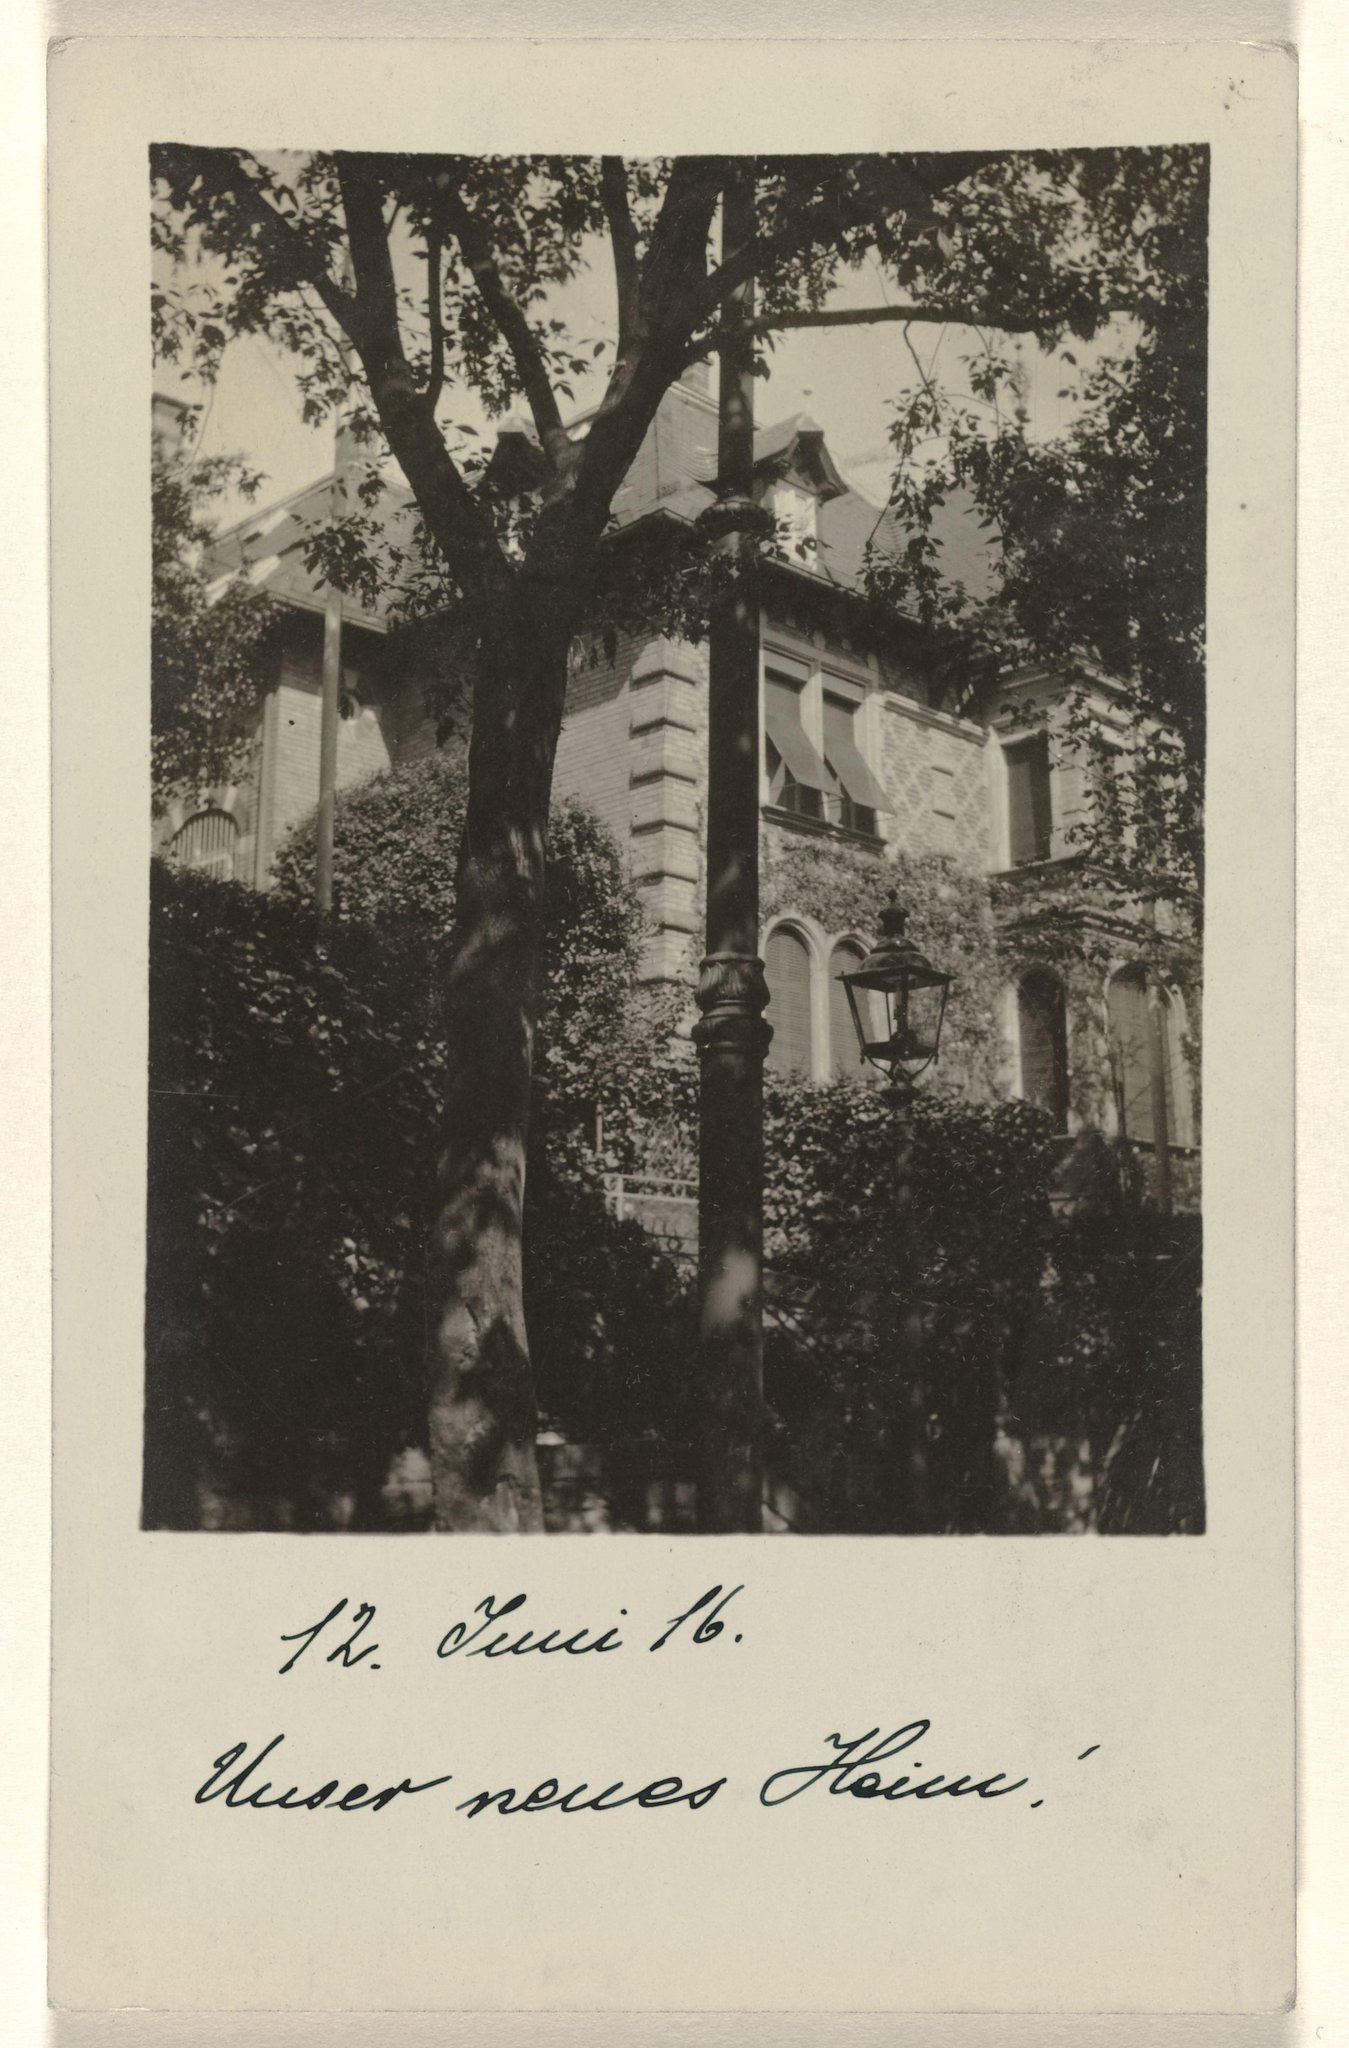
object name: photograph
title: De nieuwe woning van Josefine-Moos-Levi bezien vanaf de straatkant, met bomen op de voorgrond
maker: Anonymous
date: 1916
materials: photographic support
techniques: gelatin silver print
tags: josefine moos-levi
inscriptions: inscription: ‘Stuttgart 12 Juni 16. Mein lieber Bruder! Dabei die neueste Aufnahme unseren Hauses. Arthur hat von seiner Abreise uns damit überrascht, es ist genau die ... Font! Herzlichste Grüssen Deiner Schwester Josefine Hernn Albert Levi Hechingen Hohenzollern’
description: De nieuwe woning van Josefine-Moos-Levi bezien vanaf de straatkant, met bomen op de voorgrond.